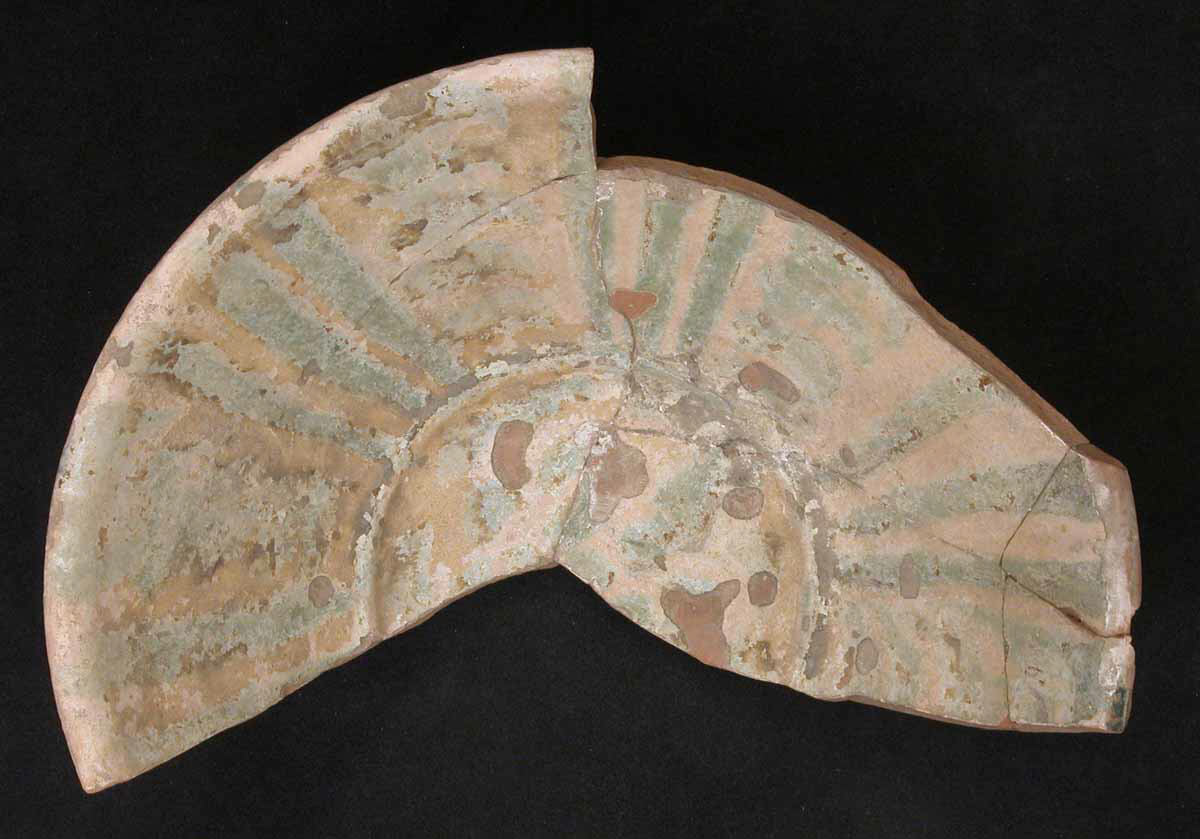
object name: fragment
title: Fragment of a Bowl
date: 701-900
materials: earthenware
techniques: glazing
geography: iraq